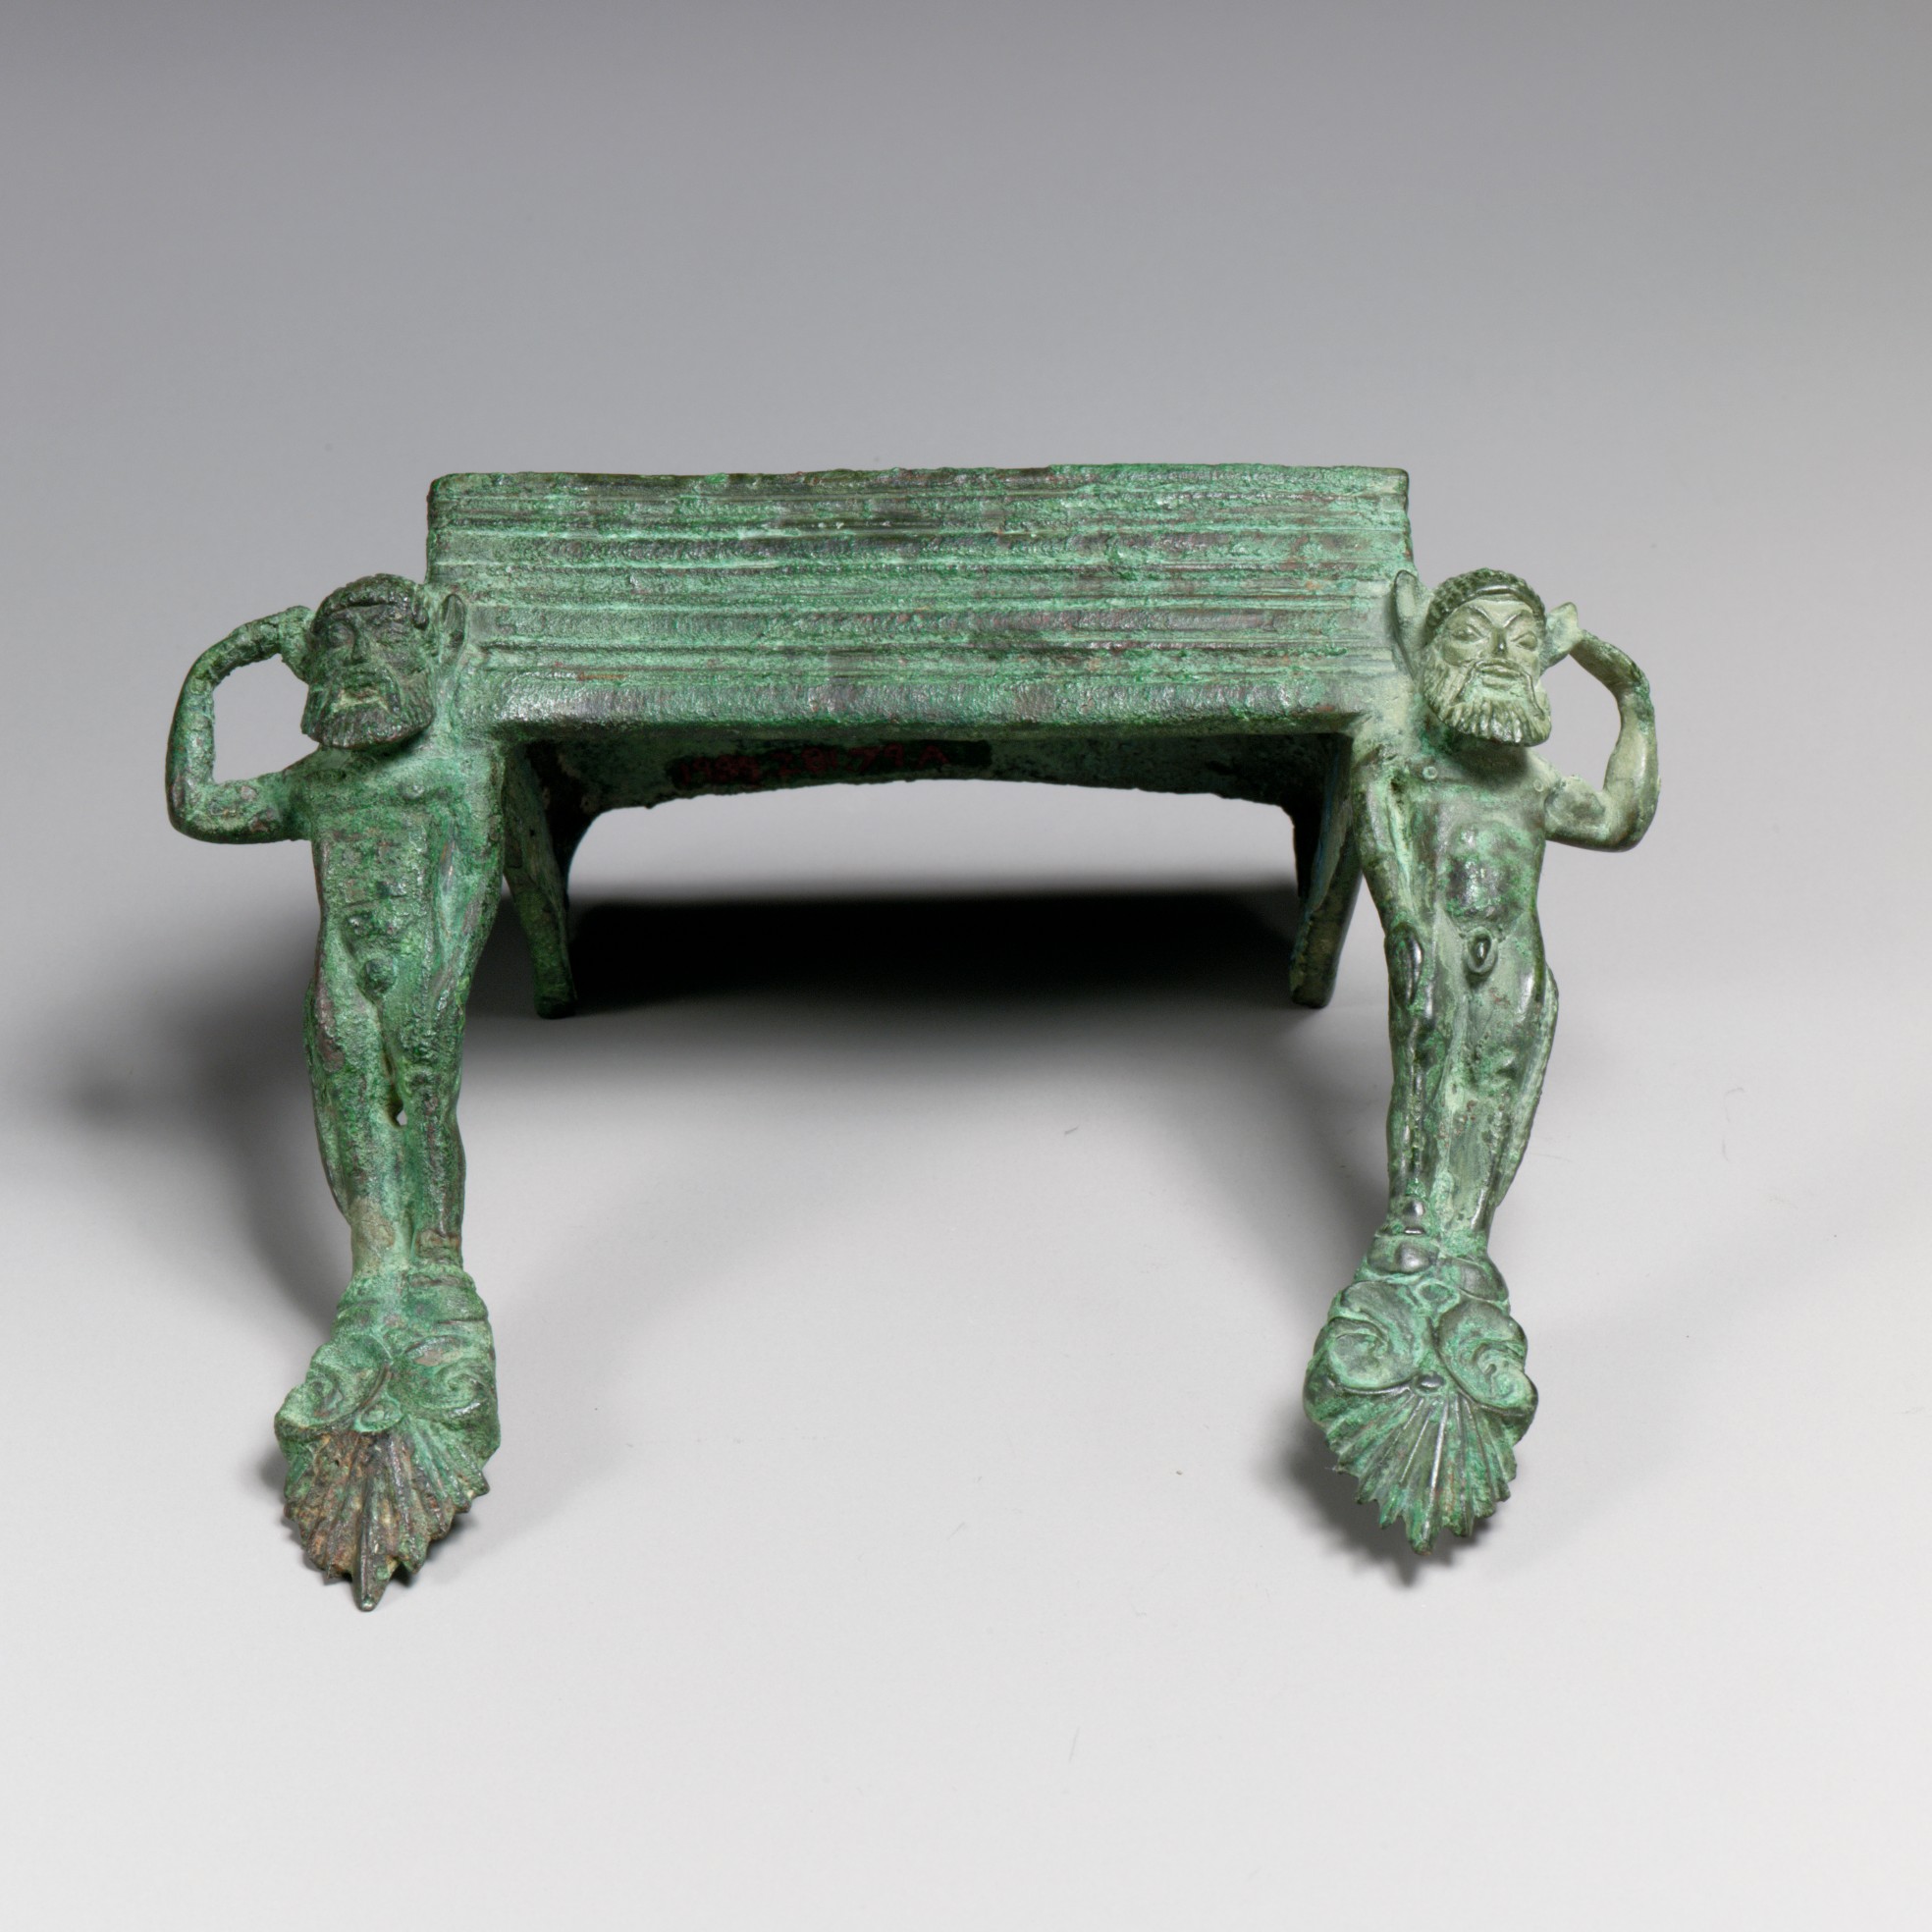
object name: handle with caryatid silenoi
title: Pair of bronze handles with satyrs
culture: etruscan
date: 500-468 BCE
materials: bronze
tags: satyrs